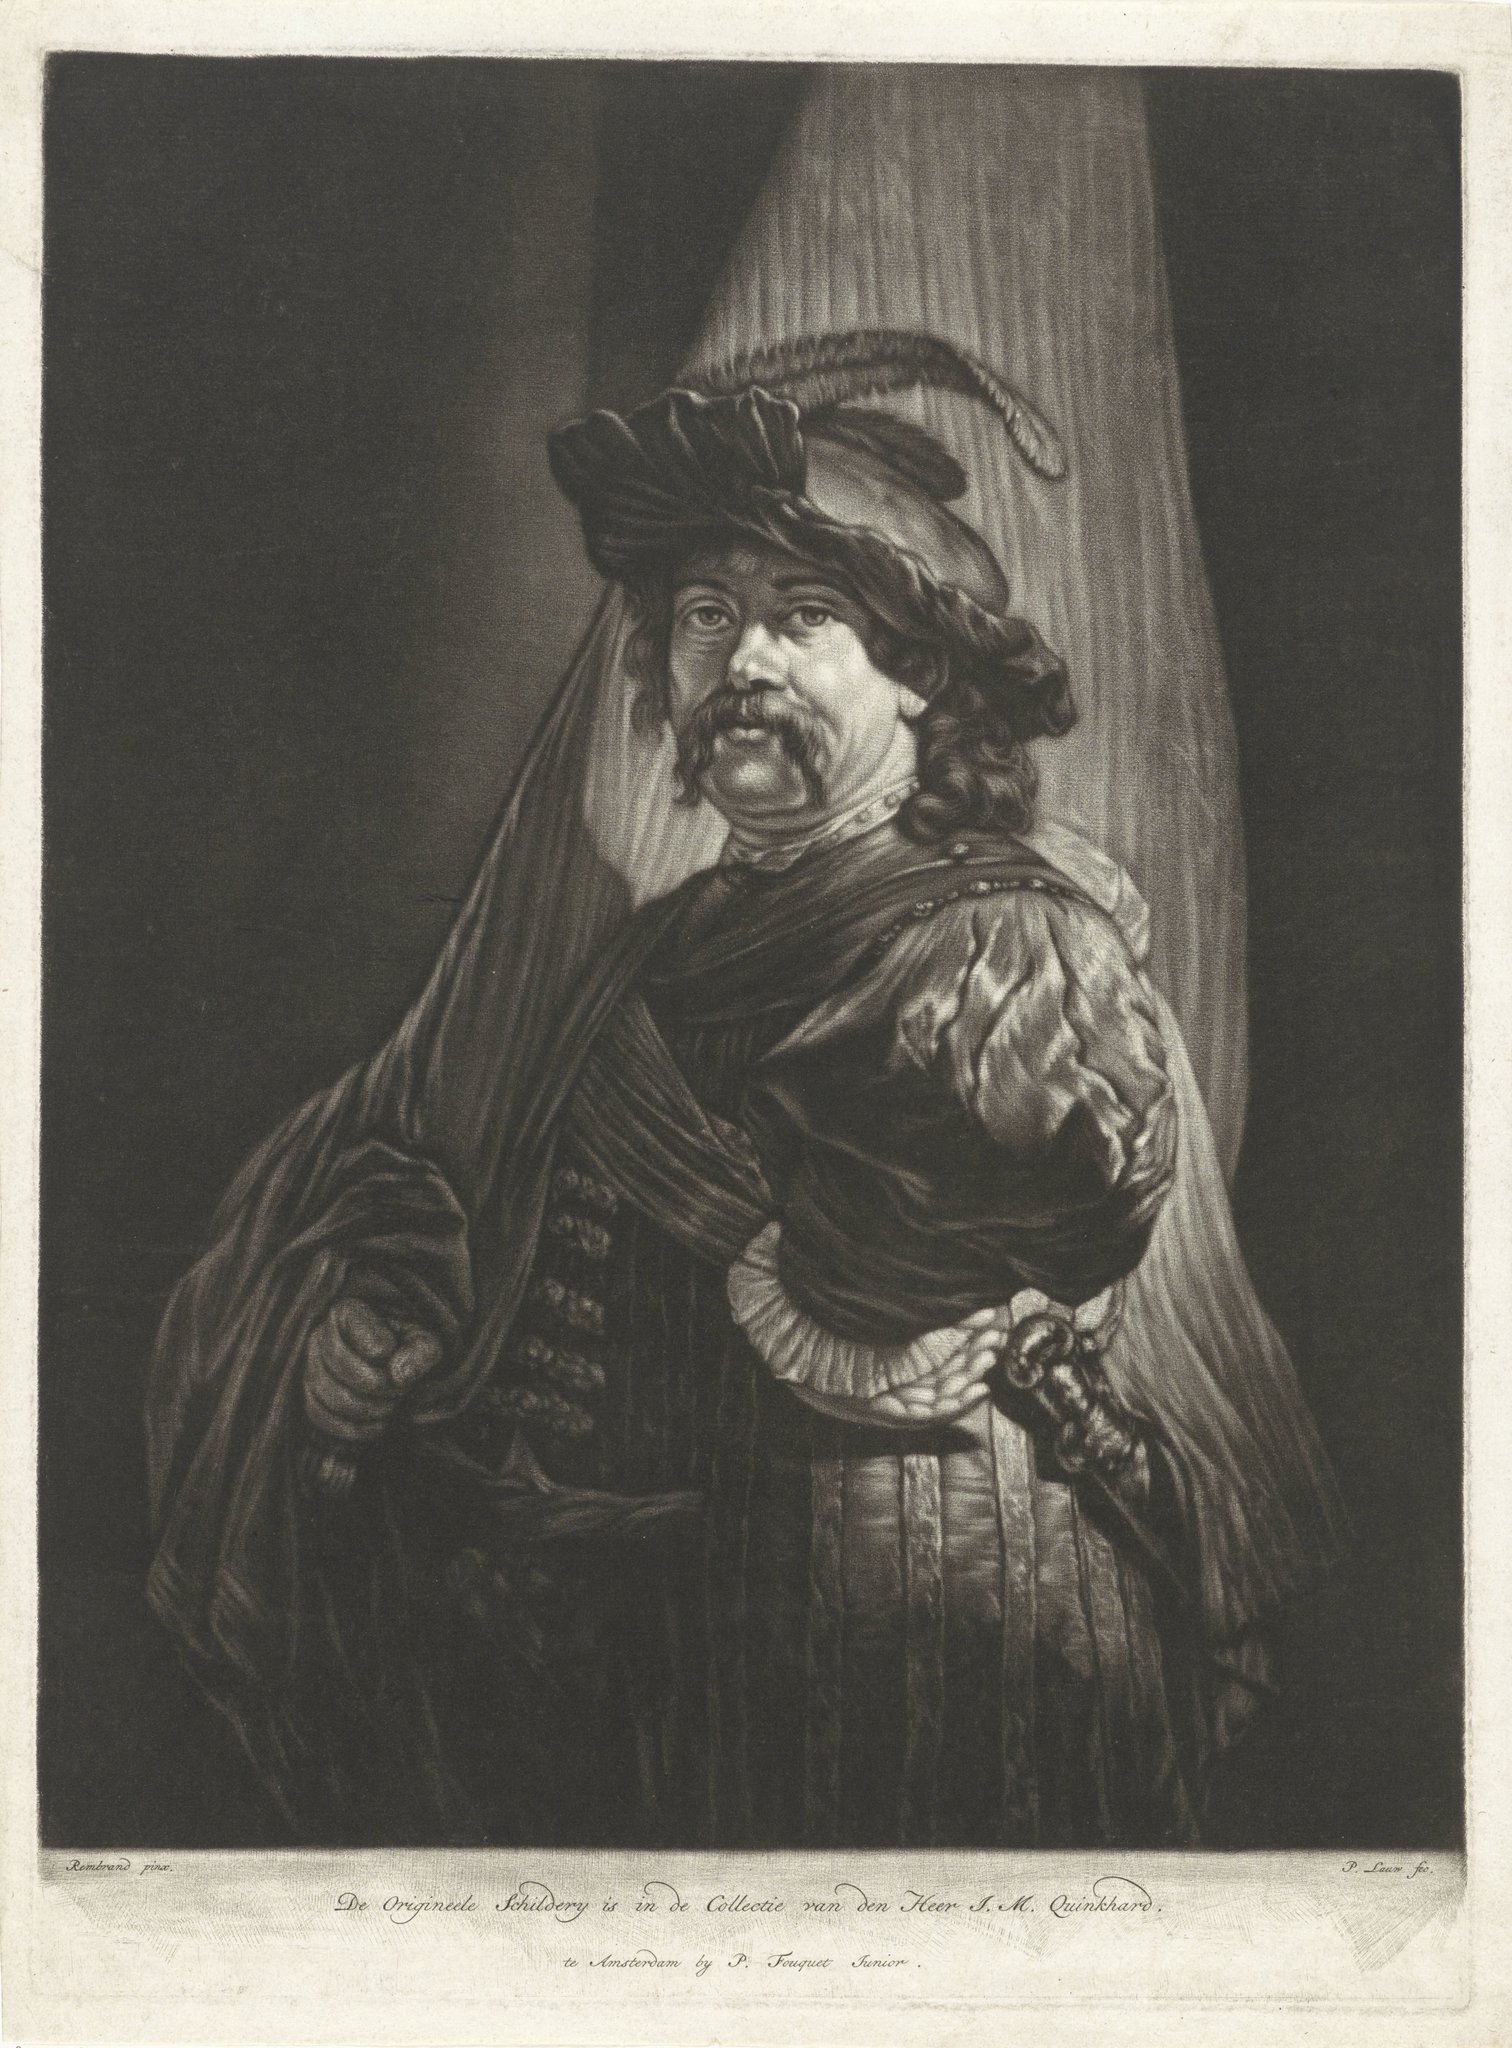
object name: print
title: Vaandeldrager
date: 1743-1772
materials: paper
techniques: engraving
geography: amsterdam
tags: standard-bearer, flag-bearer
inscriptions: collector's mark: Lugt 2228